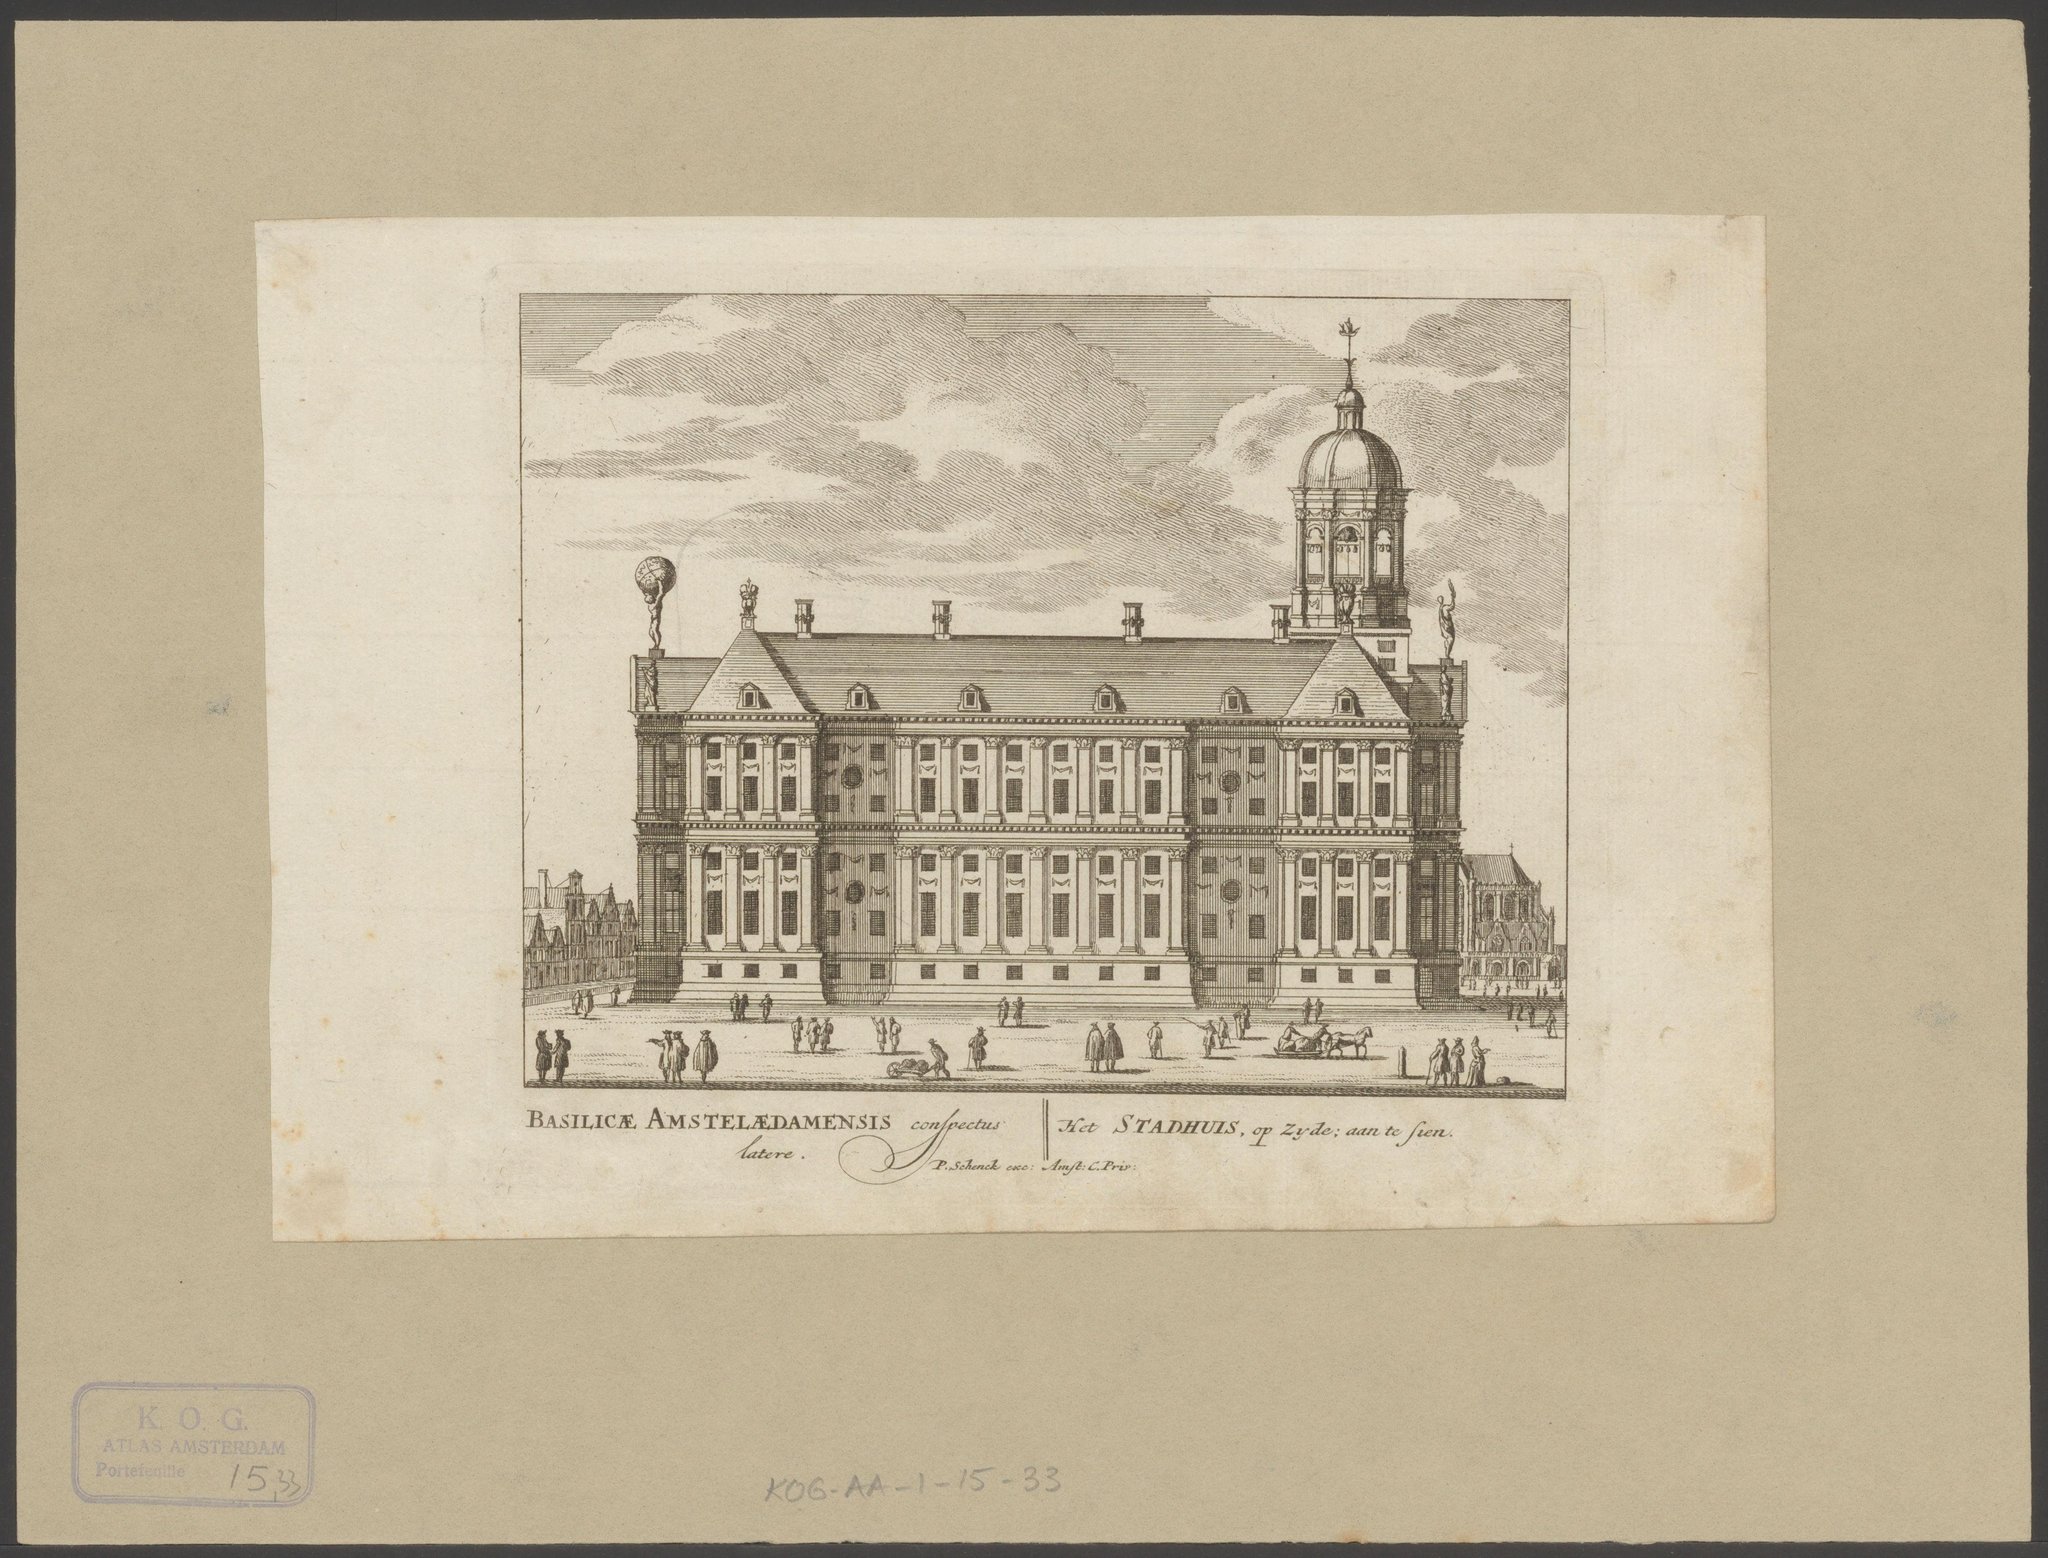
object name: print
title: Basilicae Amstelaedamensis conspectus latere / Het Stadhuis, op zyde; aan te sien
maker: Anonymous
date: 1710-1711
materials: paper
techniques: etching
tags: square, place, circus, etc., city-view in general; 'veduta', townhall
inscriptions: collector's mark: ‘15,33’ Lugt 1641b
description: Onderwerpsrubriek binnen de Atlas Amsterdam: Nieuwe Stadhuis, als Stadhuis, op de Dam.